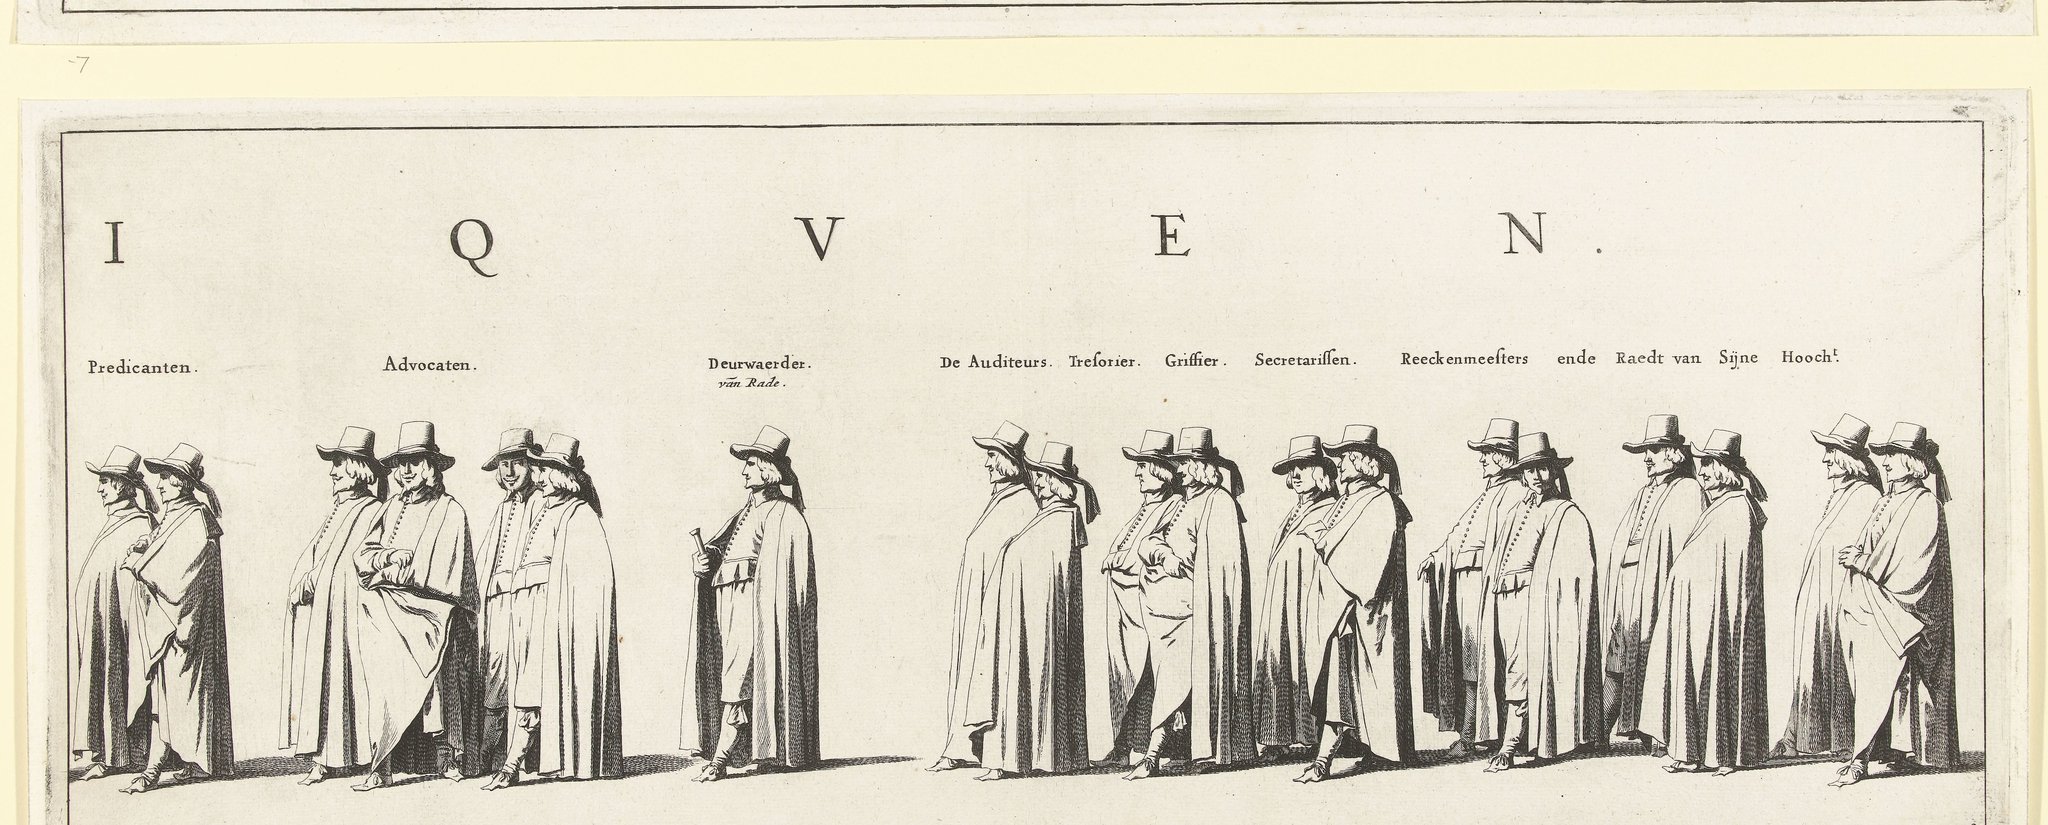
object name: print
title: De begrafenisstoet van stadhouder Frederik Hendrik te 's-Gravenhage in 1647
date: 1647-1651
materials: paper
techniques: etching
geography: amsterdam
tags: the hague, frederick henry (prince of orange), cortege, funeral procession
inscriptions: collector's mark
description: De begrafenisstoet van stadhouder Frederik Hendrik te 's-Gravenhage op 10 mei 1647. Plaat nr. 8 met een deel van de stoet, boven de personen staat hun functie. Onderdeel van een serie van 30 platen en 20 tekstbladen, bedoeld om aan elkaar geplakt te worden.